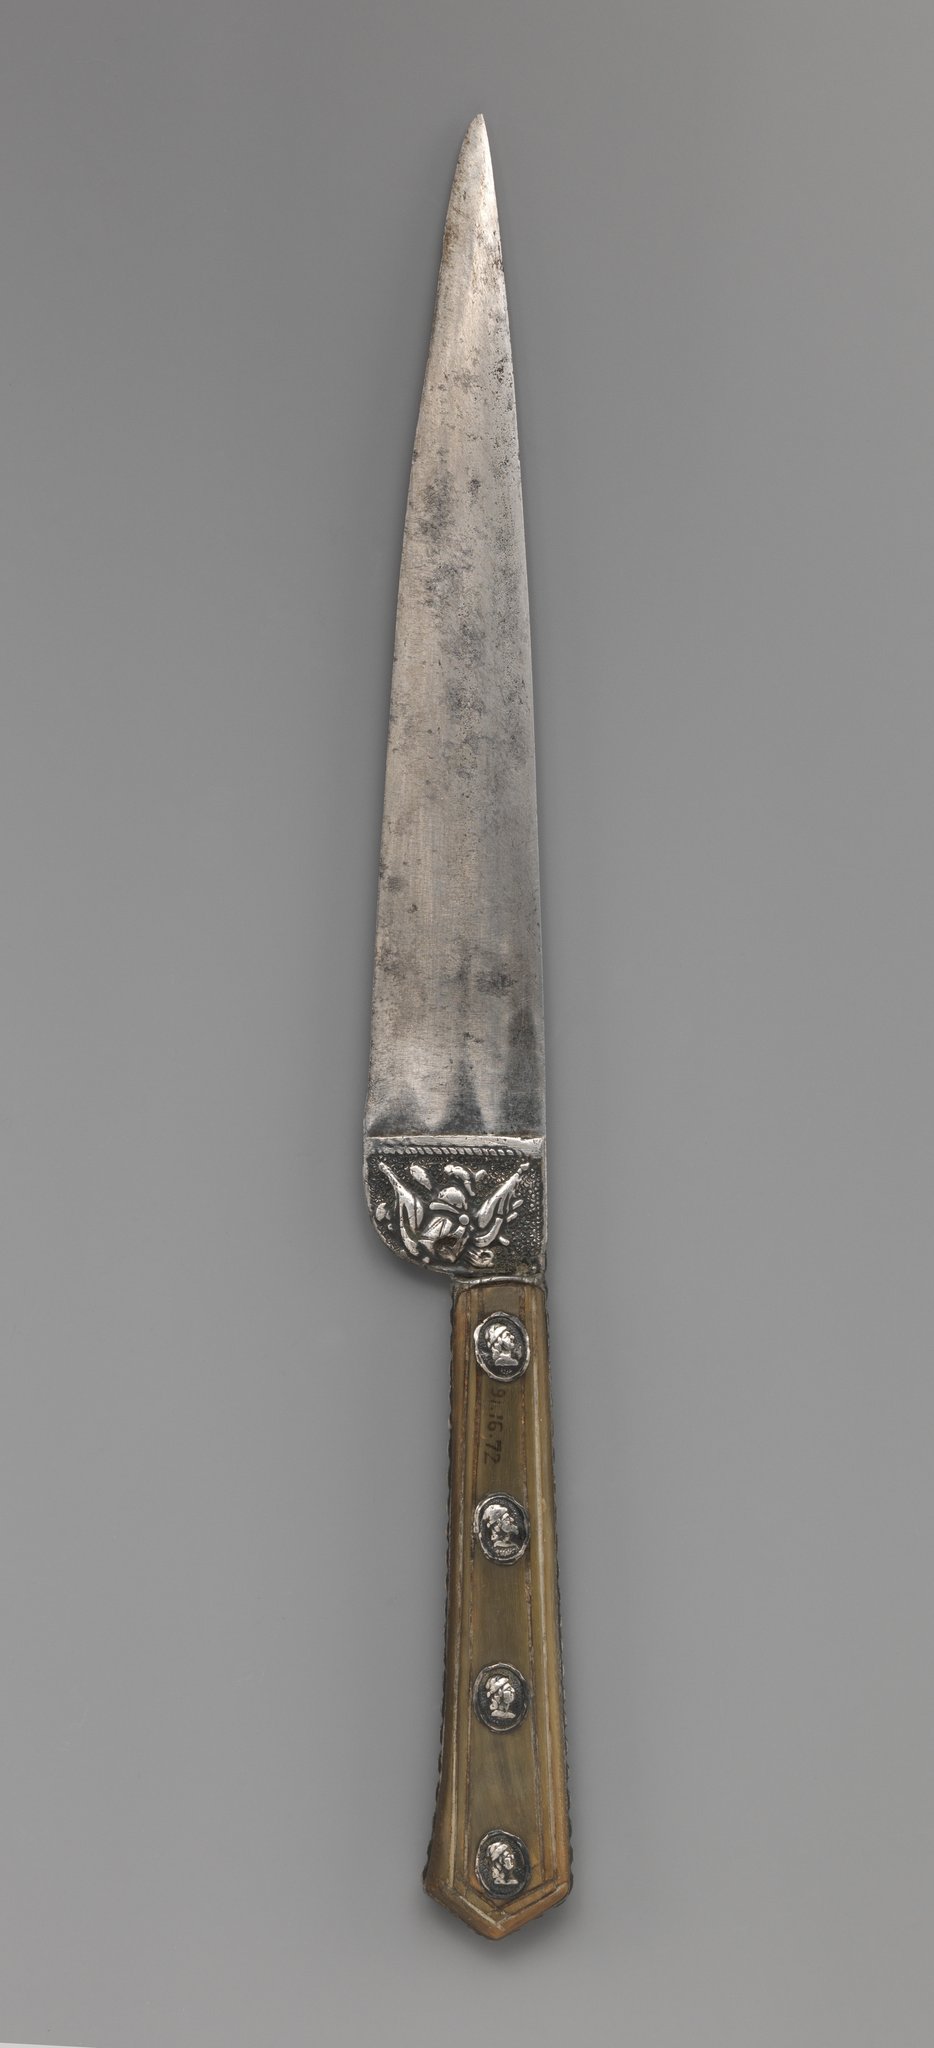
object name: table knife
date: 1701-1800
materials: silver, steel